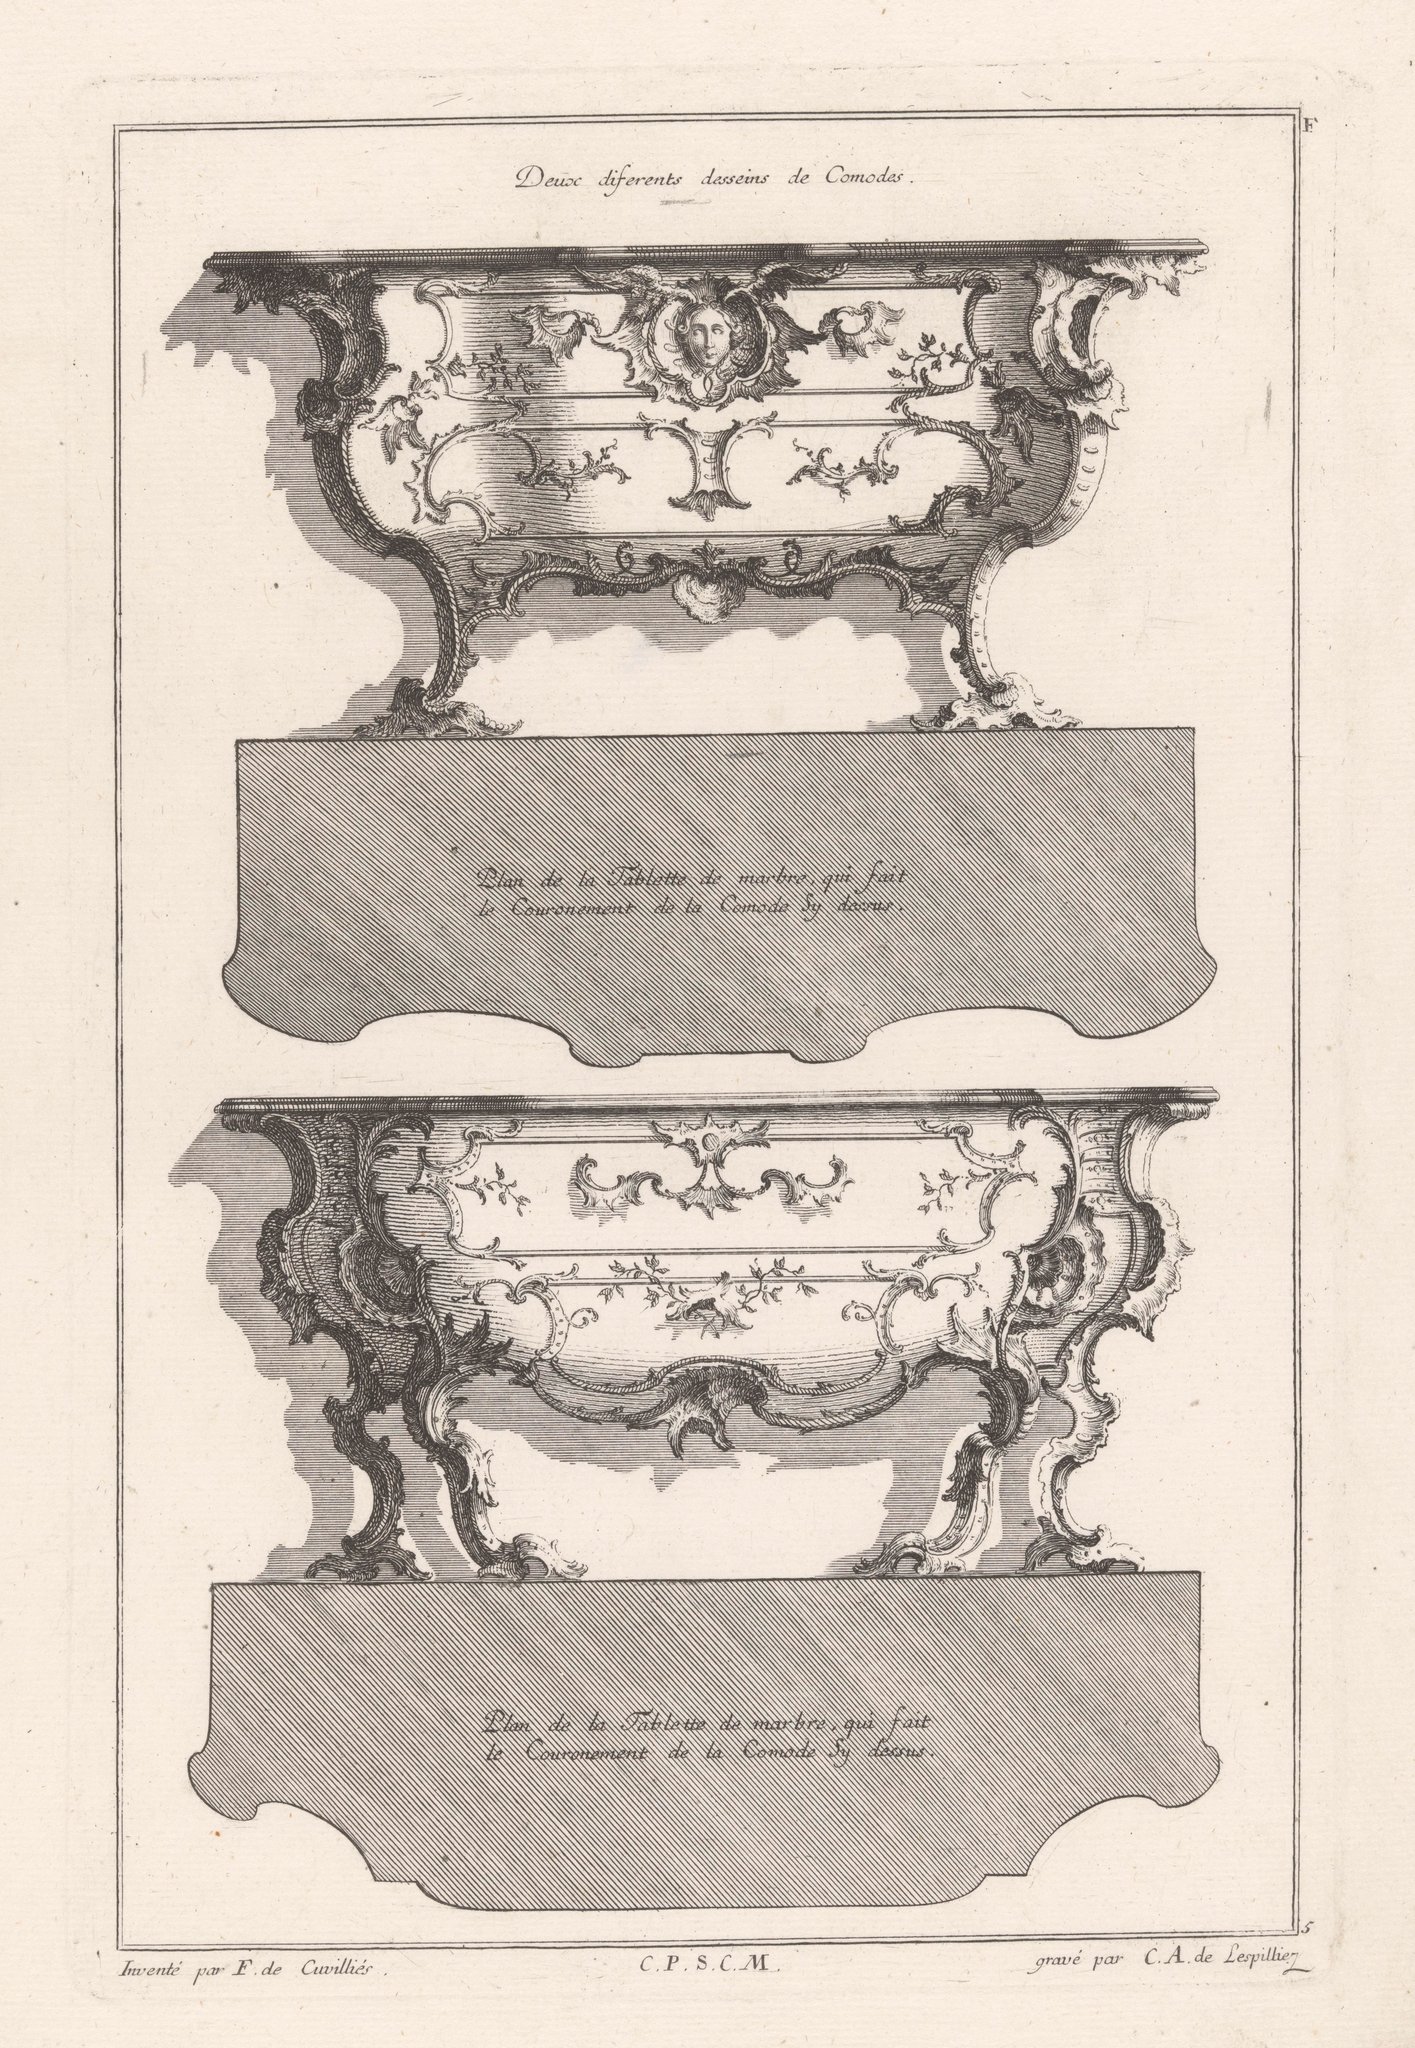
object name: print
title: Deux diferents desseins de Comodes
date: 1745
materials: paper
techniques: etching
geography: paris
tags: ornamental cupboard, mask, mascaron ~ ornament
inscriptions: collector's mark: Lugt 2760, collector's mark: Lugt 2228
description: Voor- en bovenaanzichten van twee geornamenteerde commodes met rocailles, boven met vrouwelijk masker.